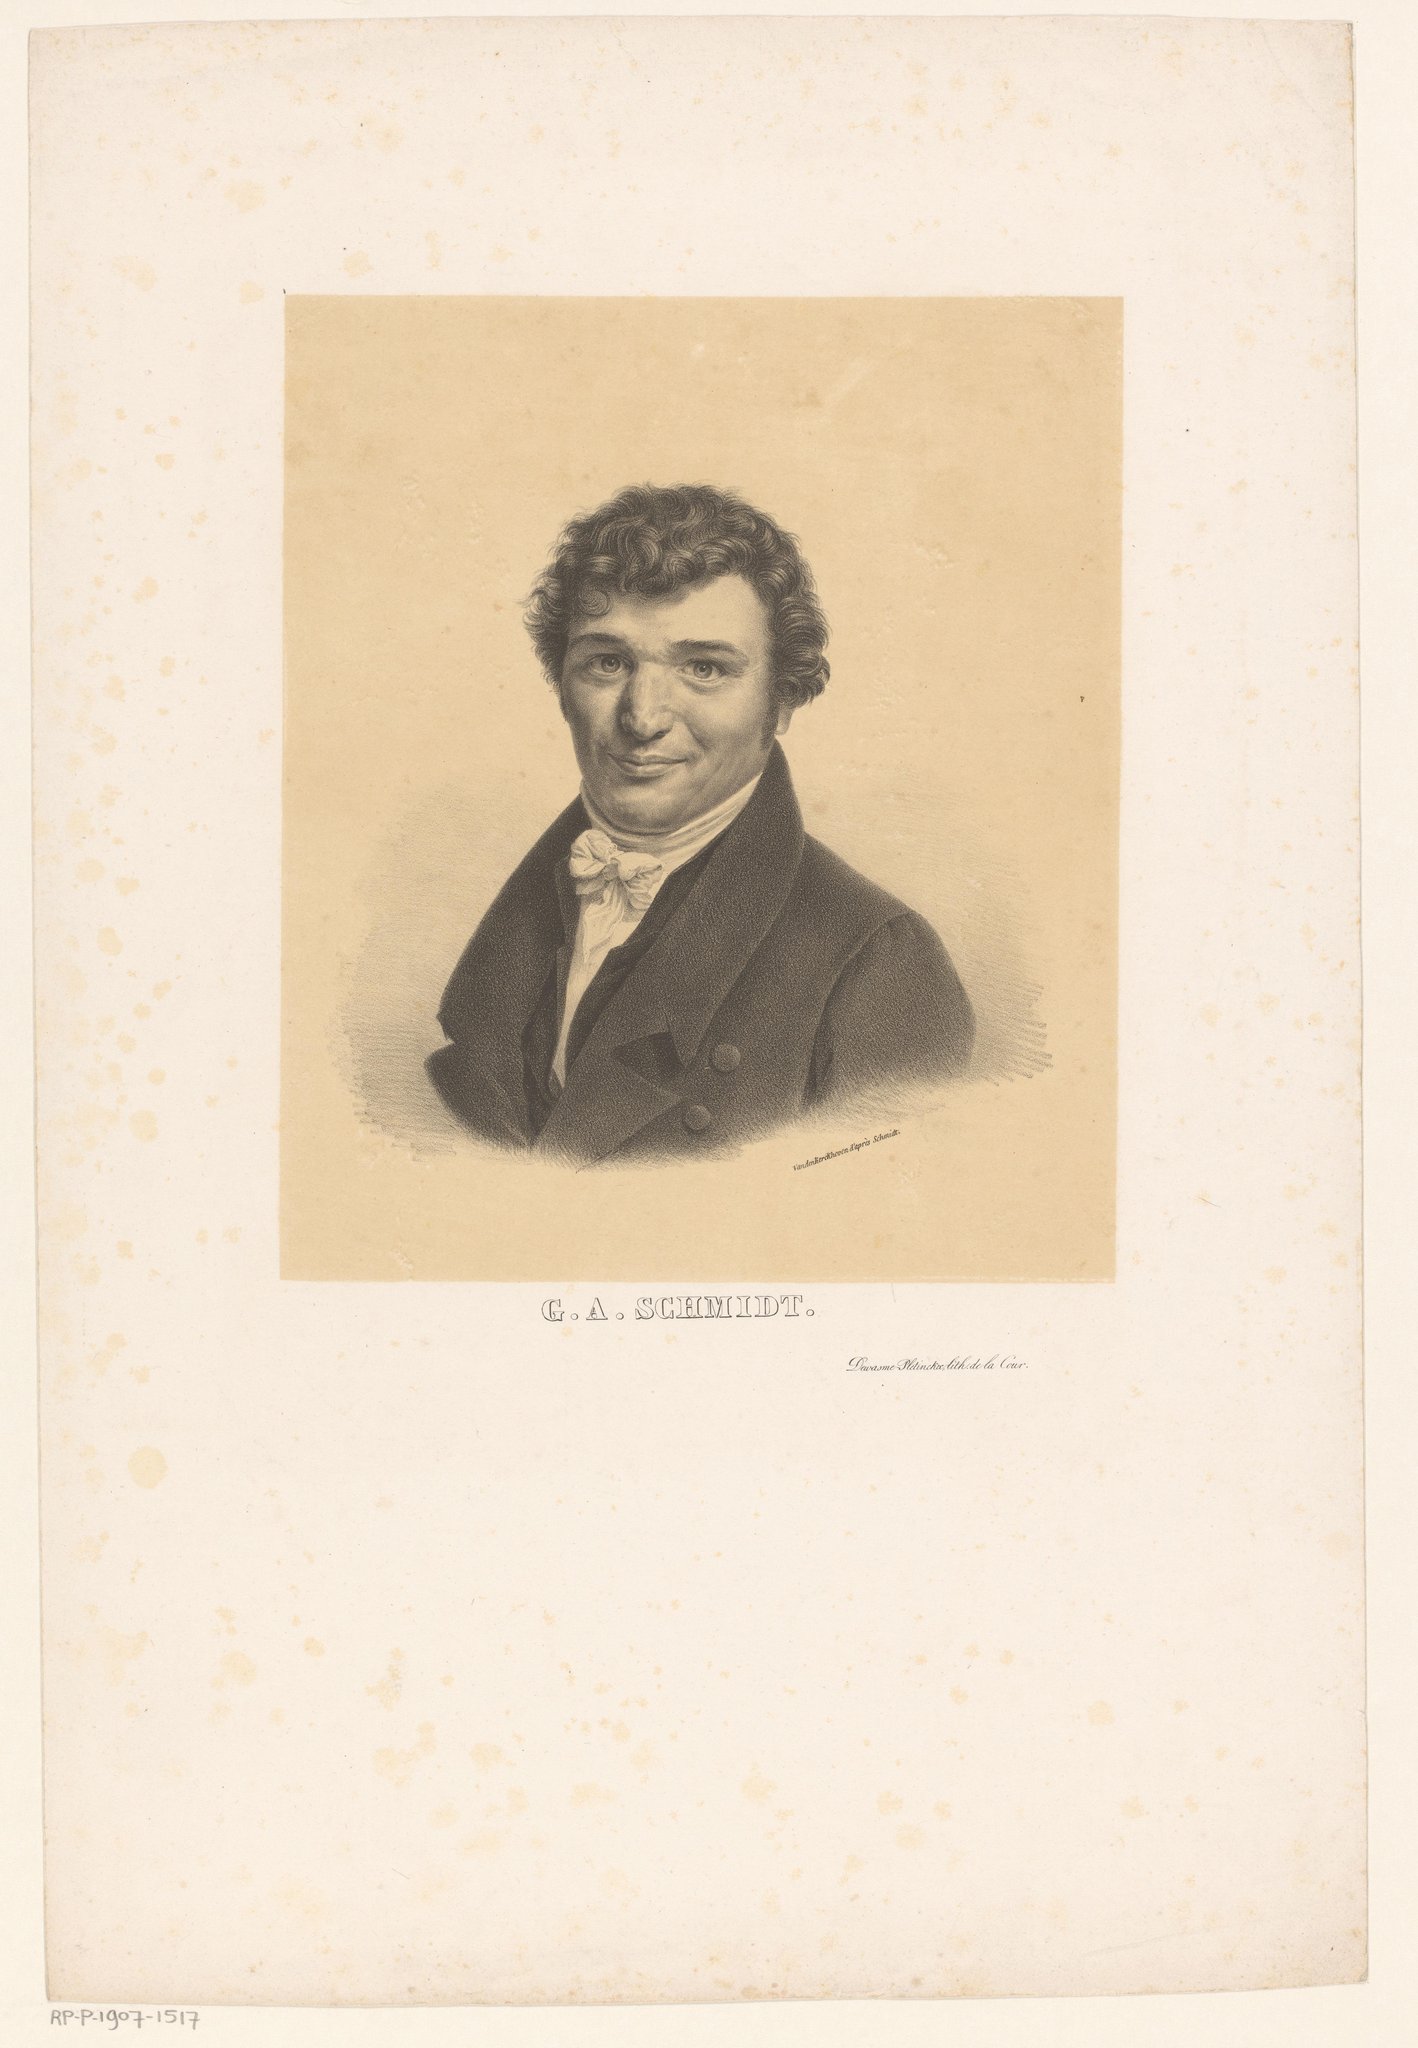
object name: print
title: G.A. Schmidt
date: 1826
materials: paper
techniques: tone lithography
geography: brussels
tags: dordrecht, painter, print maker, draughtsman, george adam schmidt, historical persons, portrait, self-portrait of painter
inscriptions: collector's mark: Lugt 2228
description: Prent verschenen in: Galerie des peintres des Ecoles Flamandes et Hollandaises. Brussel: A. Wahlen, 1826.